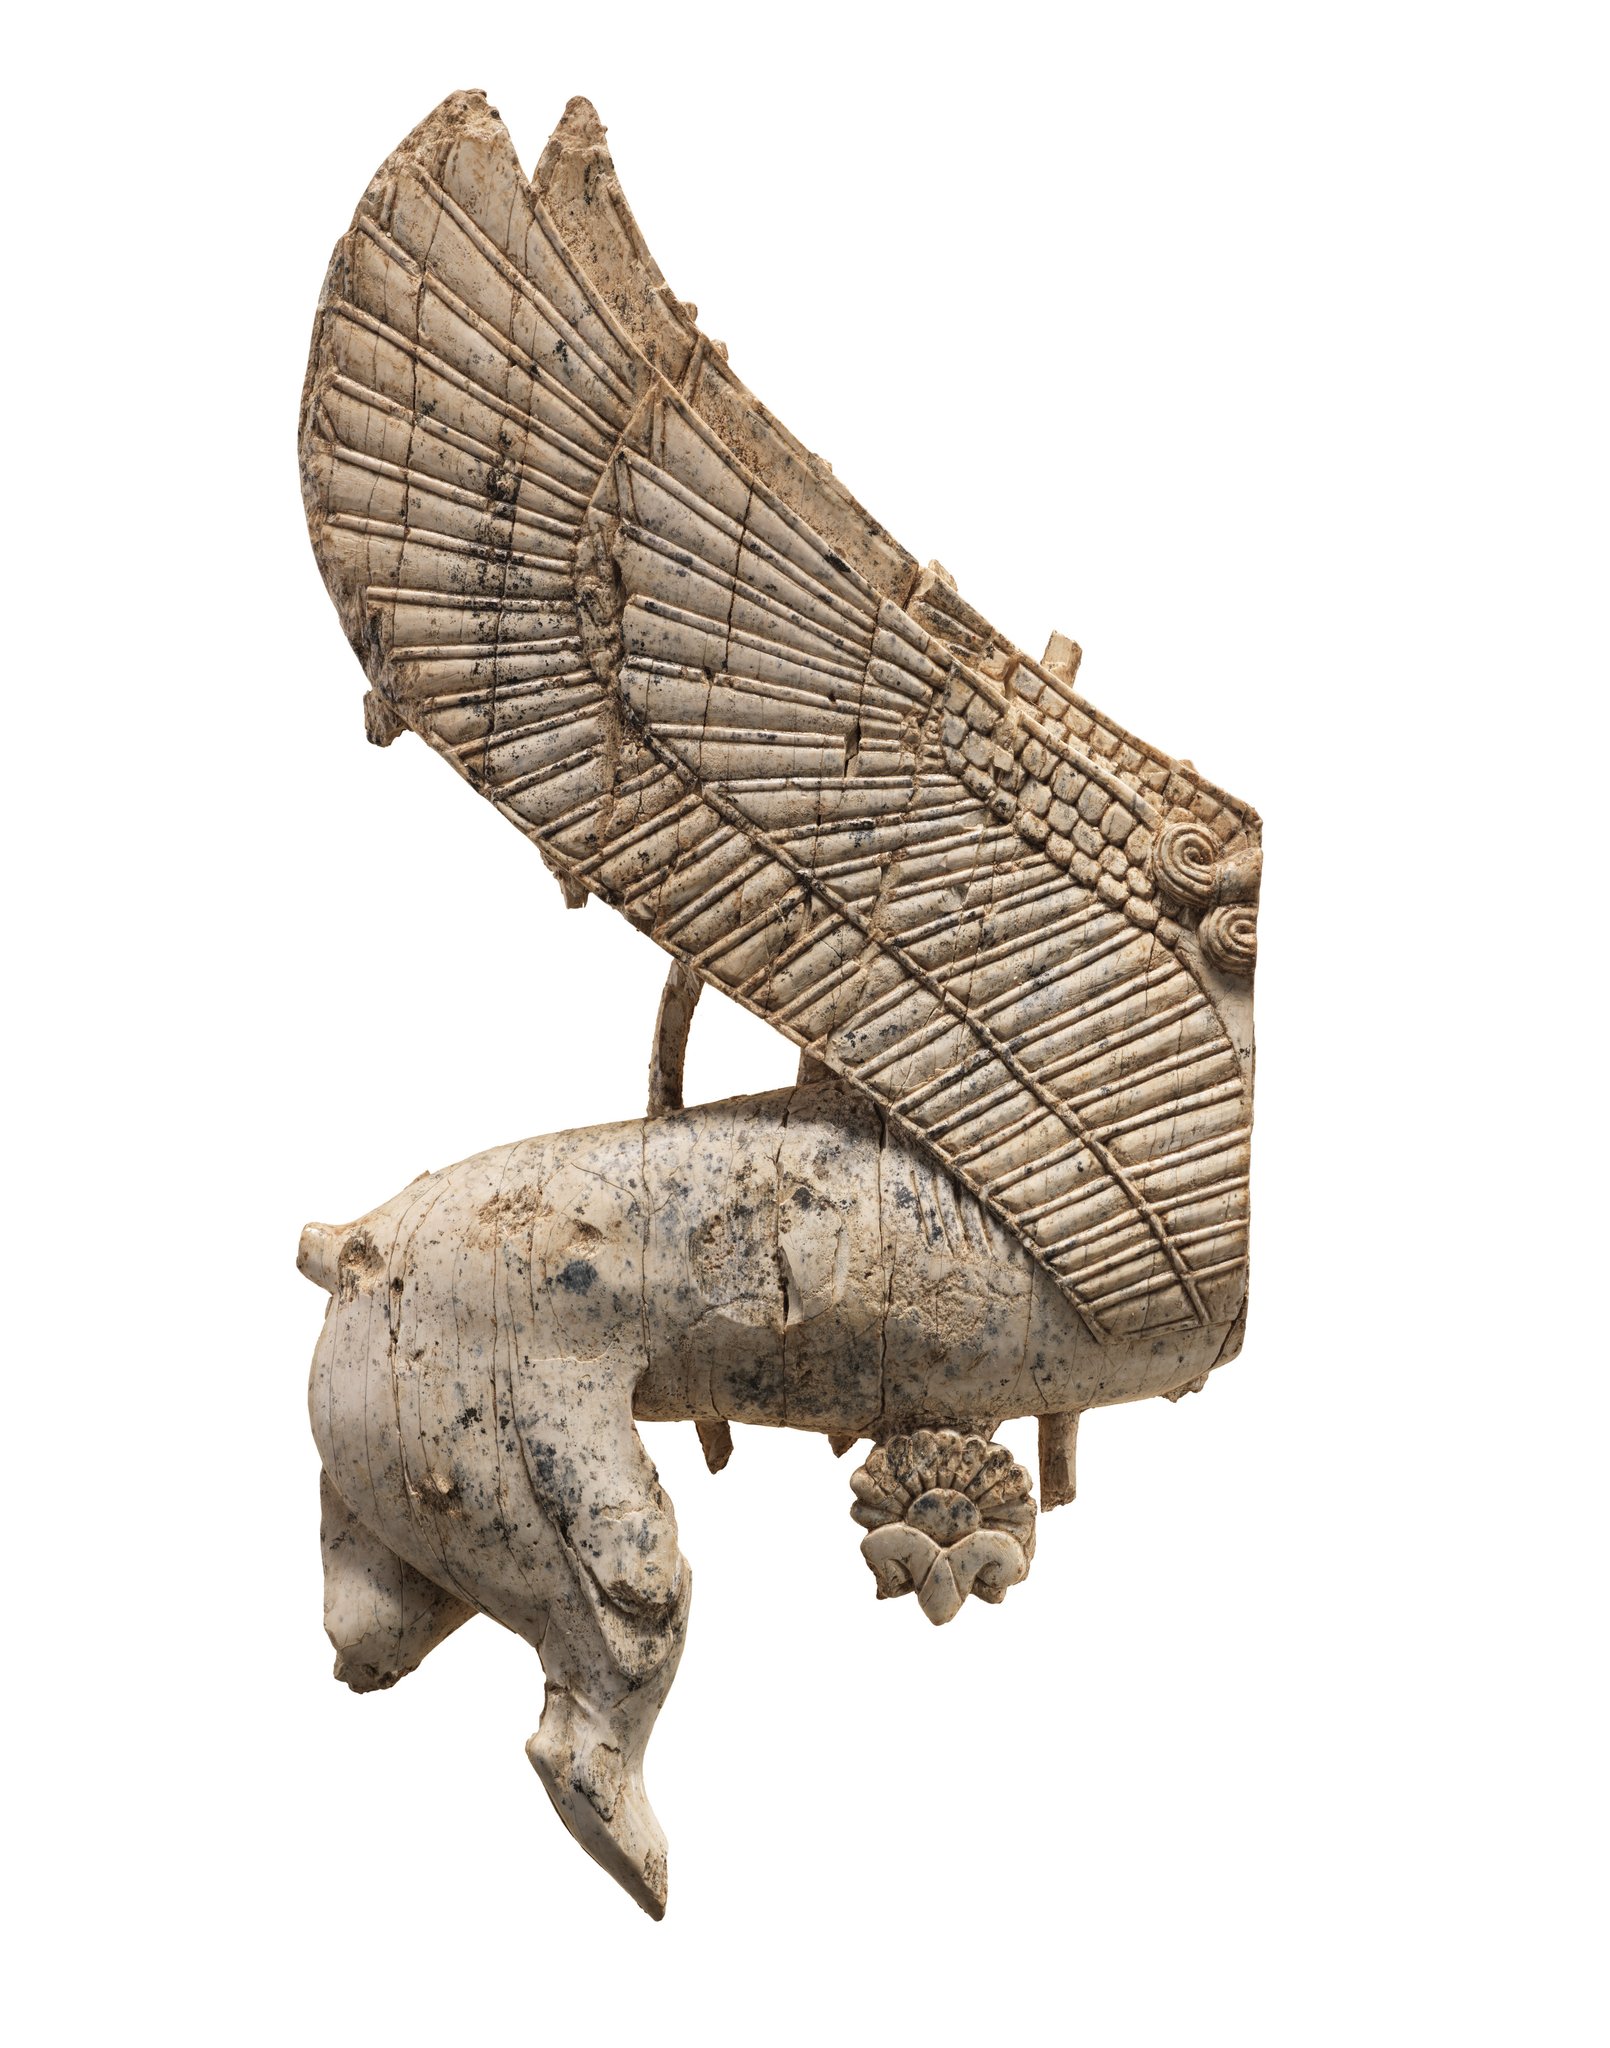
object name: relief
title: Openwork furniture plaque with sphinx striding through a floral landscape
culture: assyrian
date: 900-701 BCE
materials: ivory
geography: mesopotamia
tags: sphinx